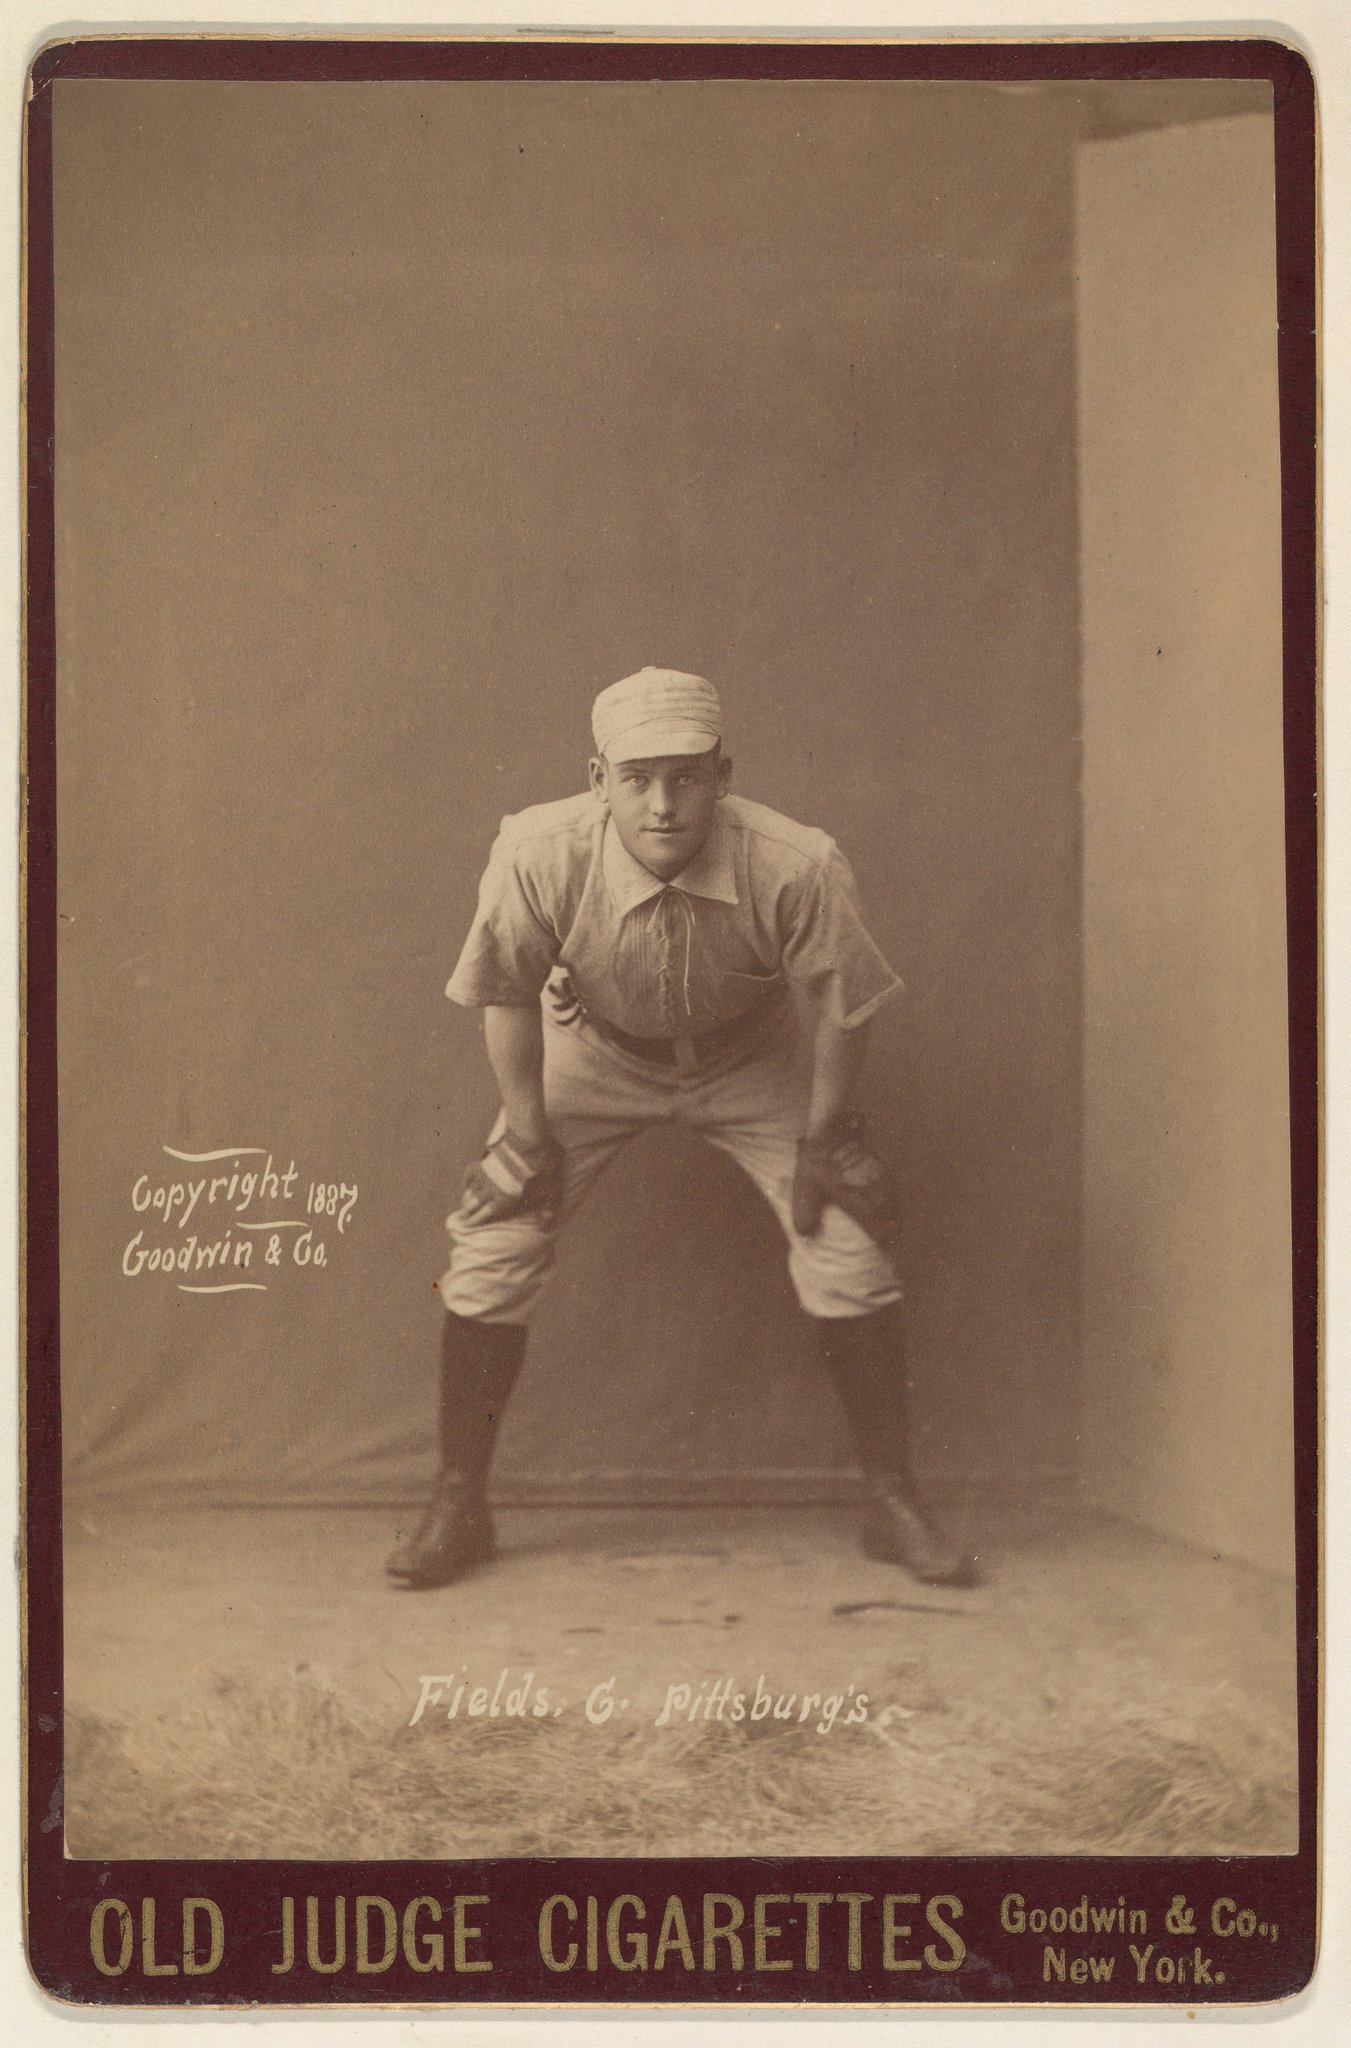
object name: baseball card, photograph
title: Fields, Catcher, Pittsburgh, from the series Old Judge Cigarettes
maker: goodwin & company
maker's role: publisher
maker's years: 1850-1950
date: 1887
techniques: albumen print, photography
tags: men,portraits,baseball,athletes